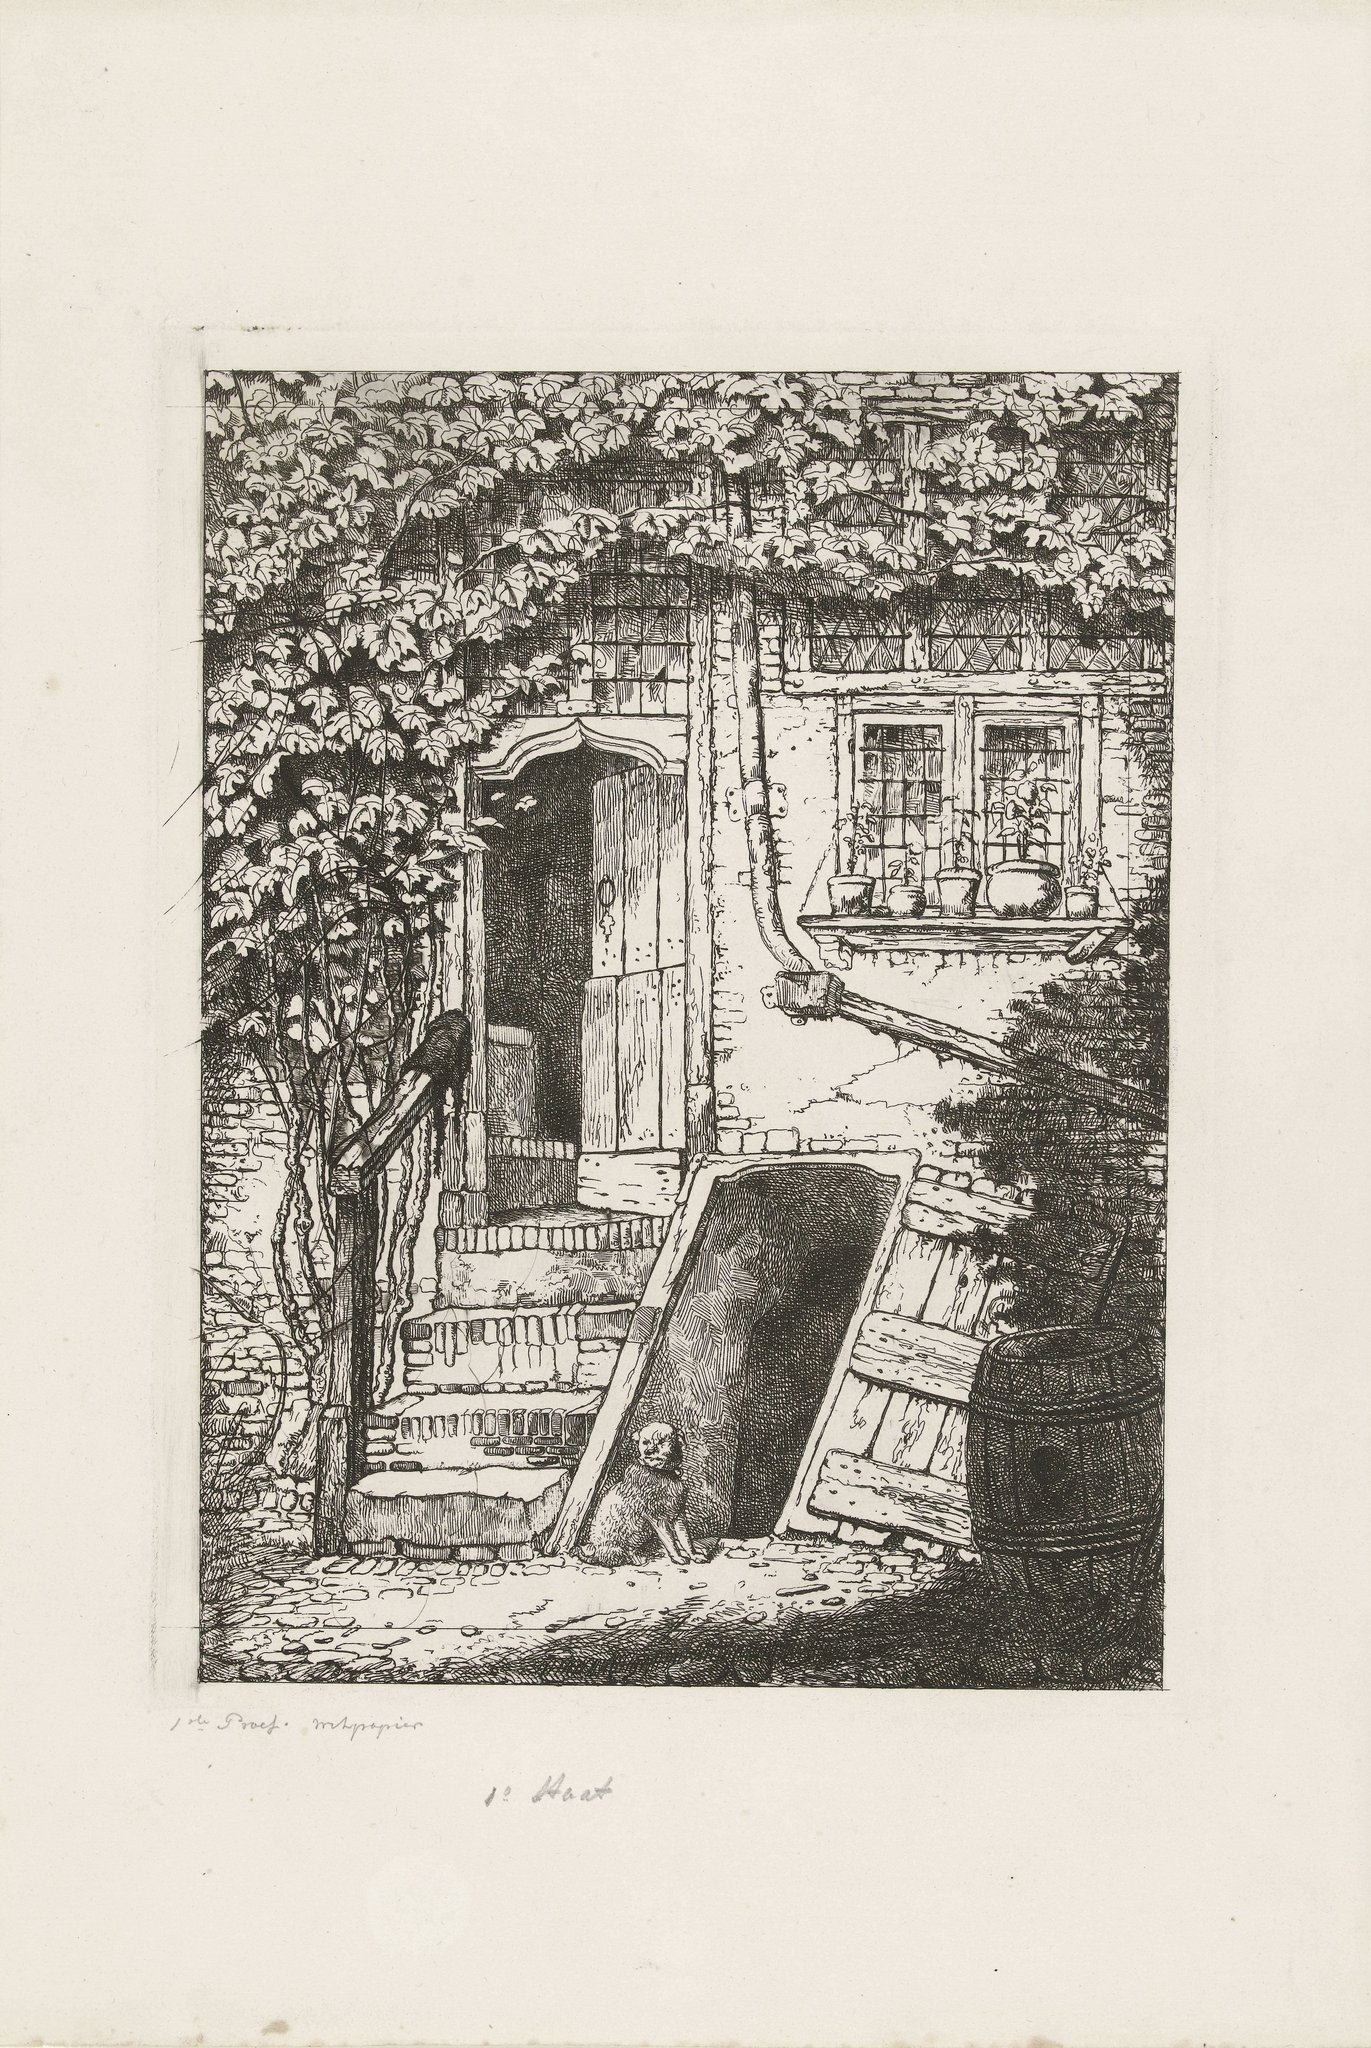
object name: print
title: Façade van een huis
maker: jacobus ludovicus cornet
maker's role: draughtsman, print maker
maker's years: 1815-1882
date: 1825-1882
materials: paper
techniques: etching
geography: leiden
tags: front façade, dog, plants and herbs: ivy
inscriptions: collector's mark: Lugt 2228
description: Façade van een huis. Een trap leidt naar het portaal en een half open staande deur. De kelderdeur staat ook open. Een schoothondje zit voor de kelderdeuropening.